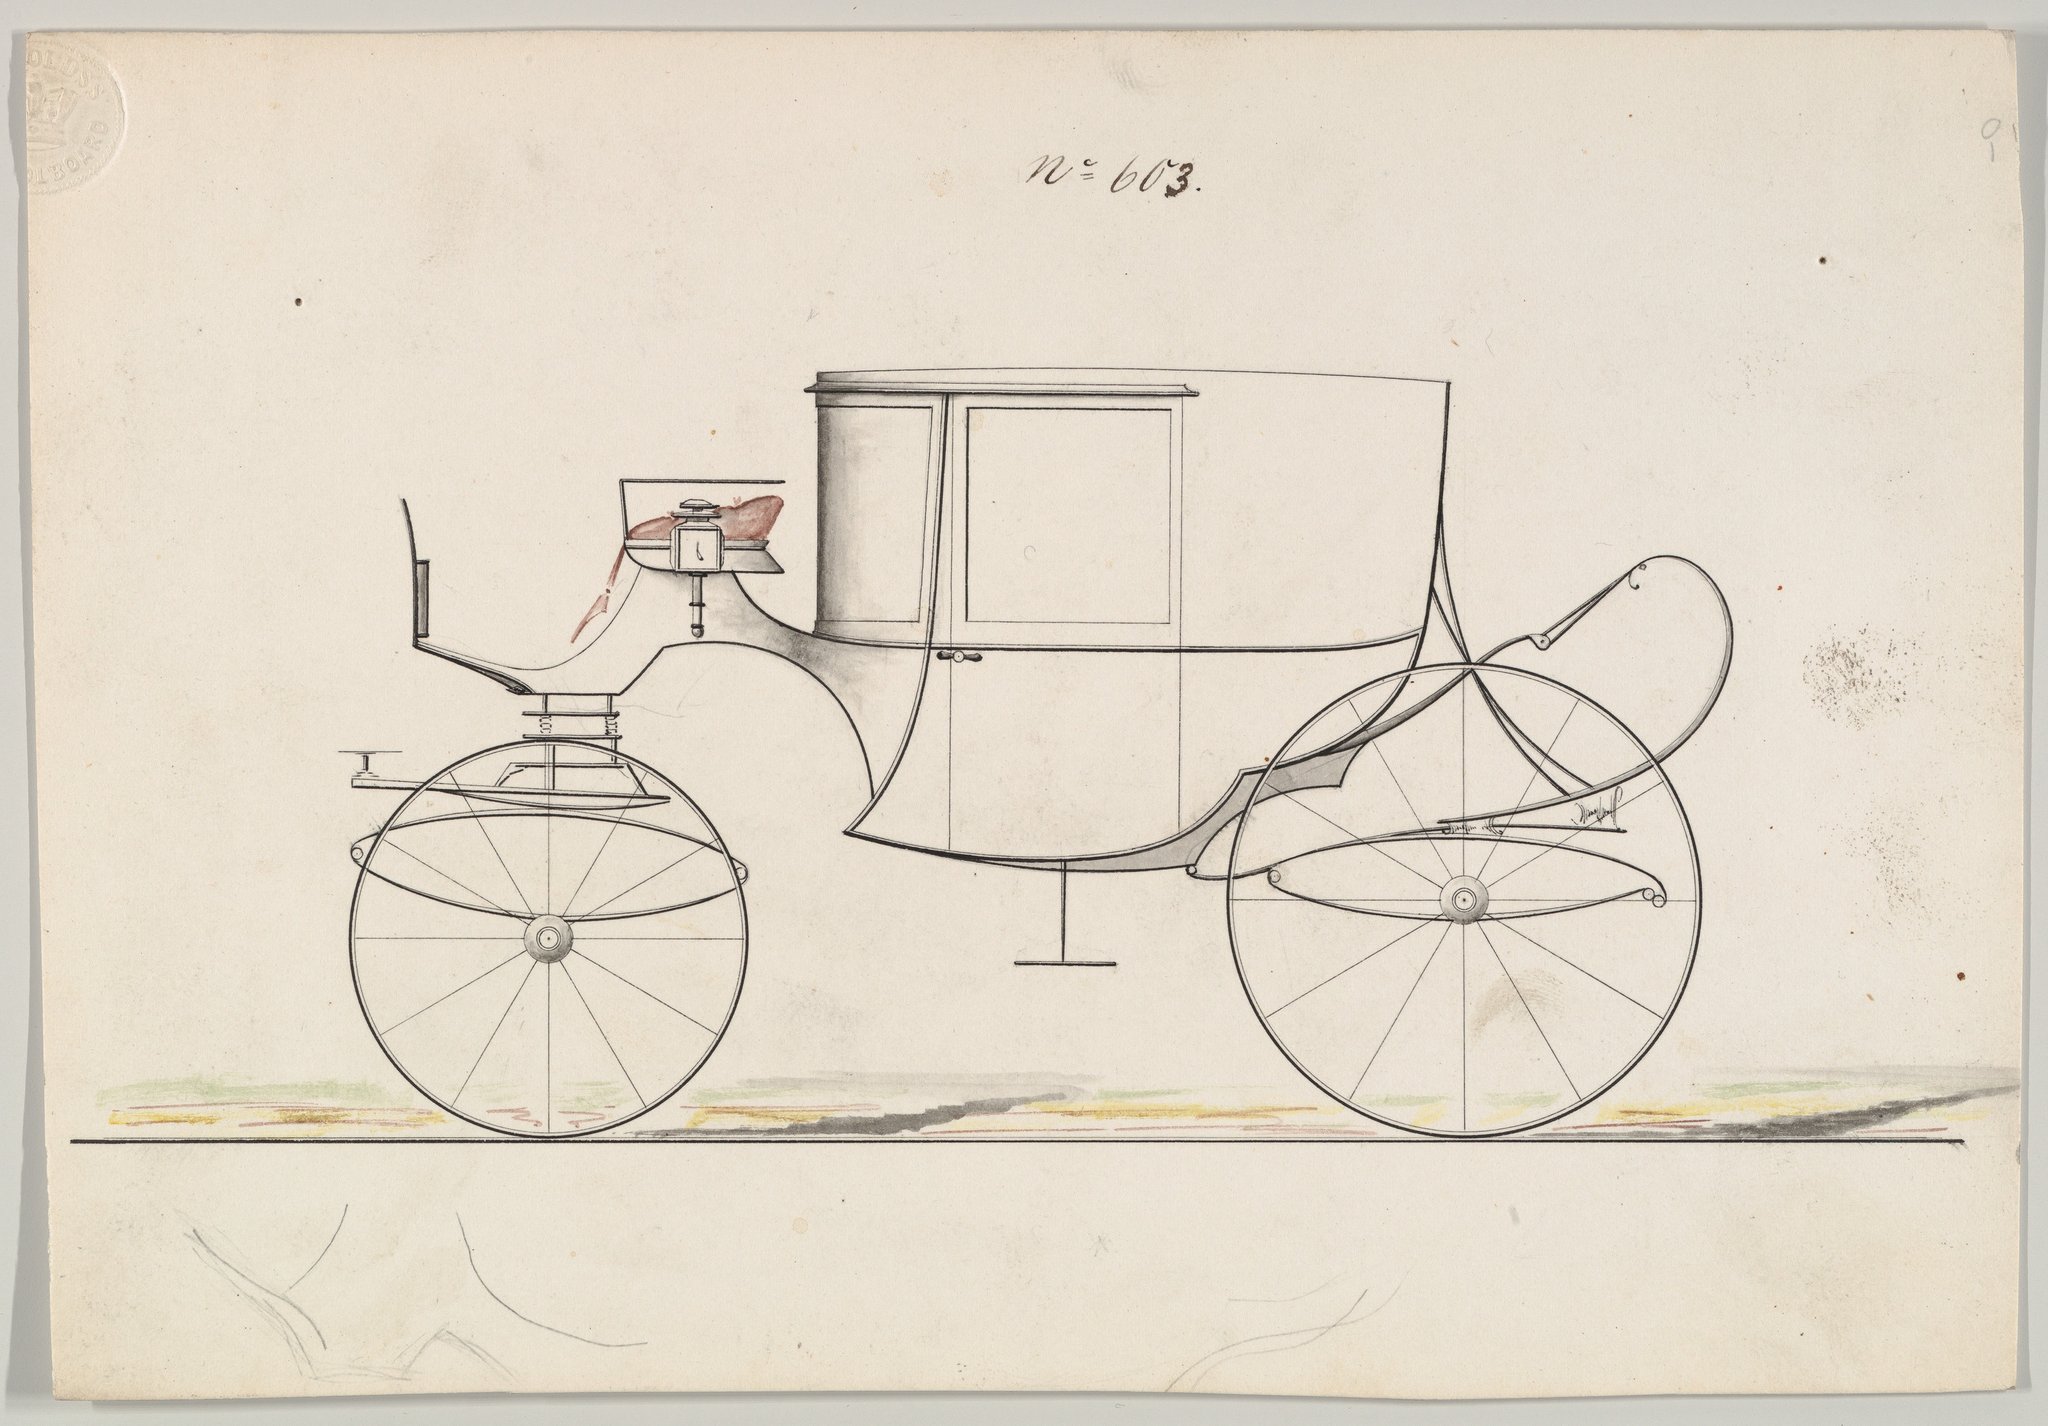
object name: drawing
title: Clarence #603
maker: brewster & co.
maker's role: manufacturer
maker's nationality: american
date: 1850-1870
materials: ink, watercolor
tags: carriages